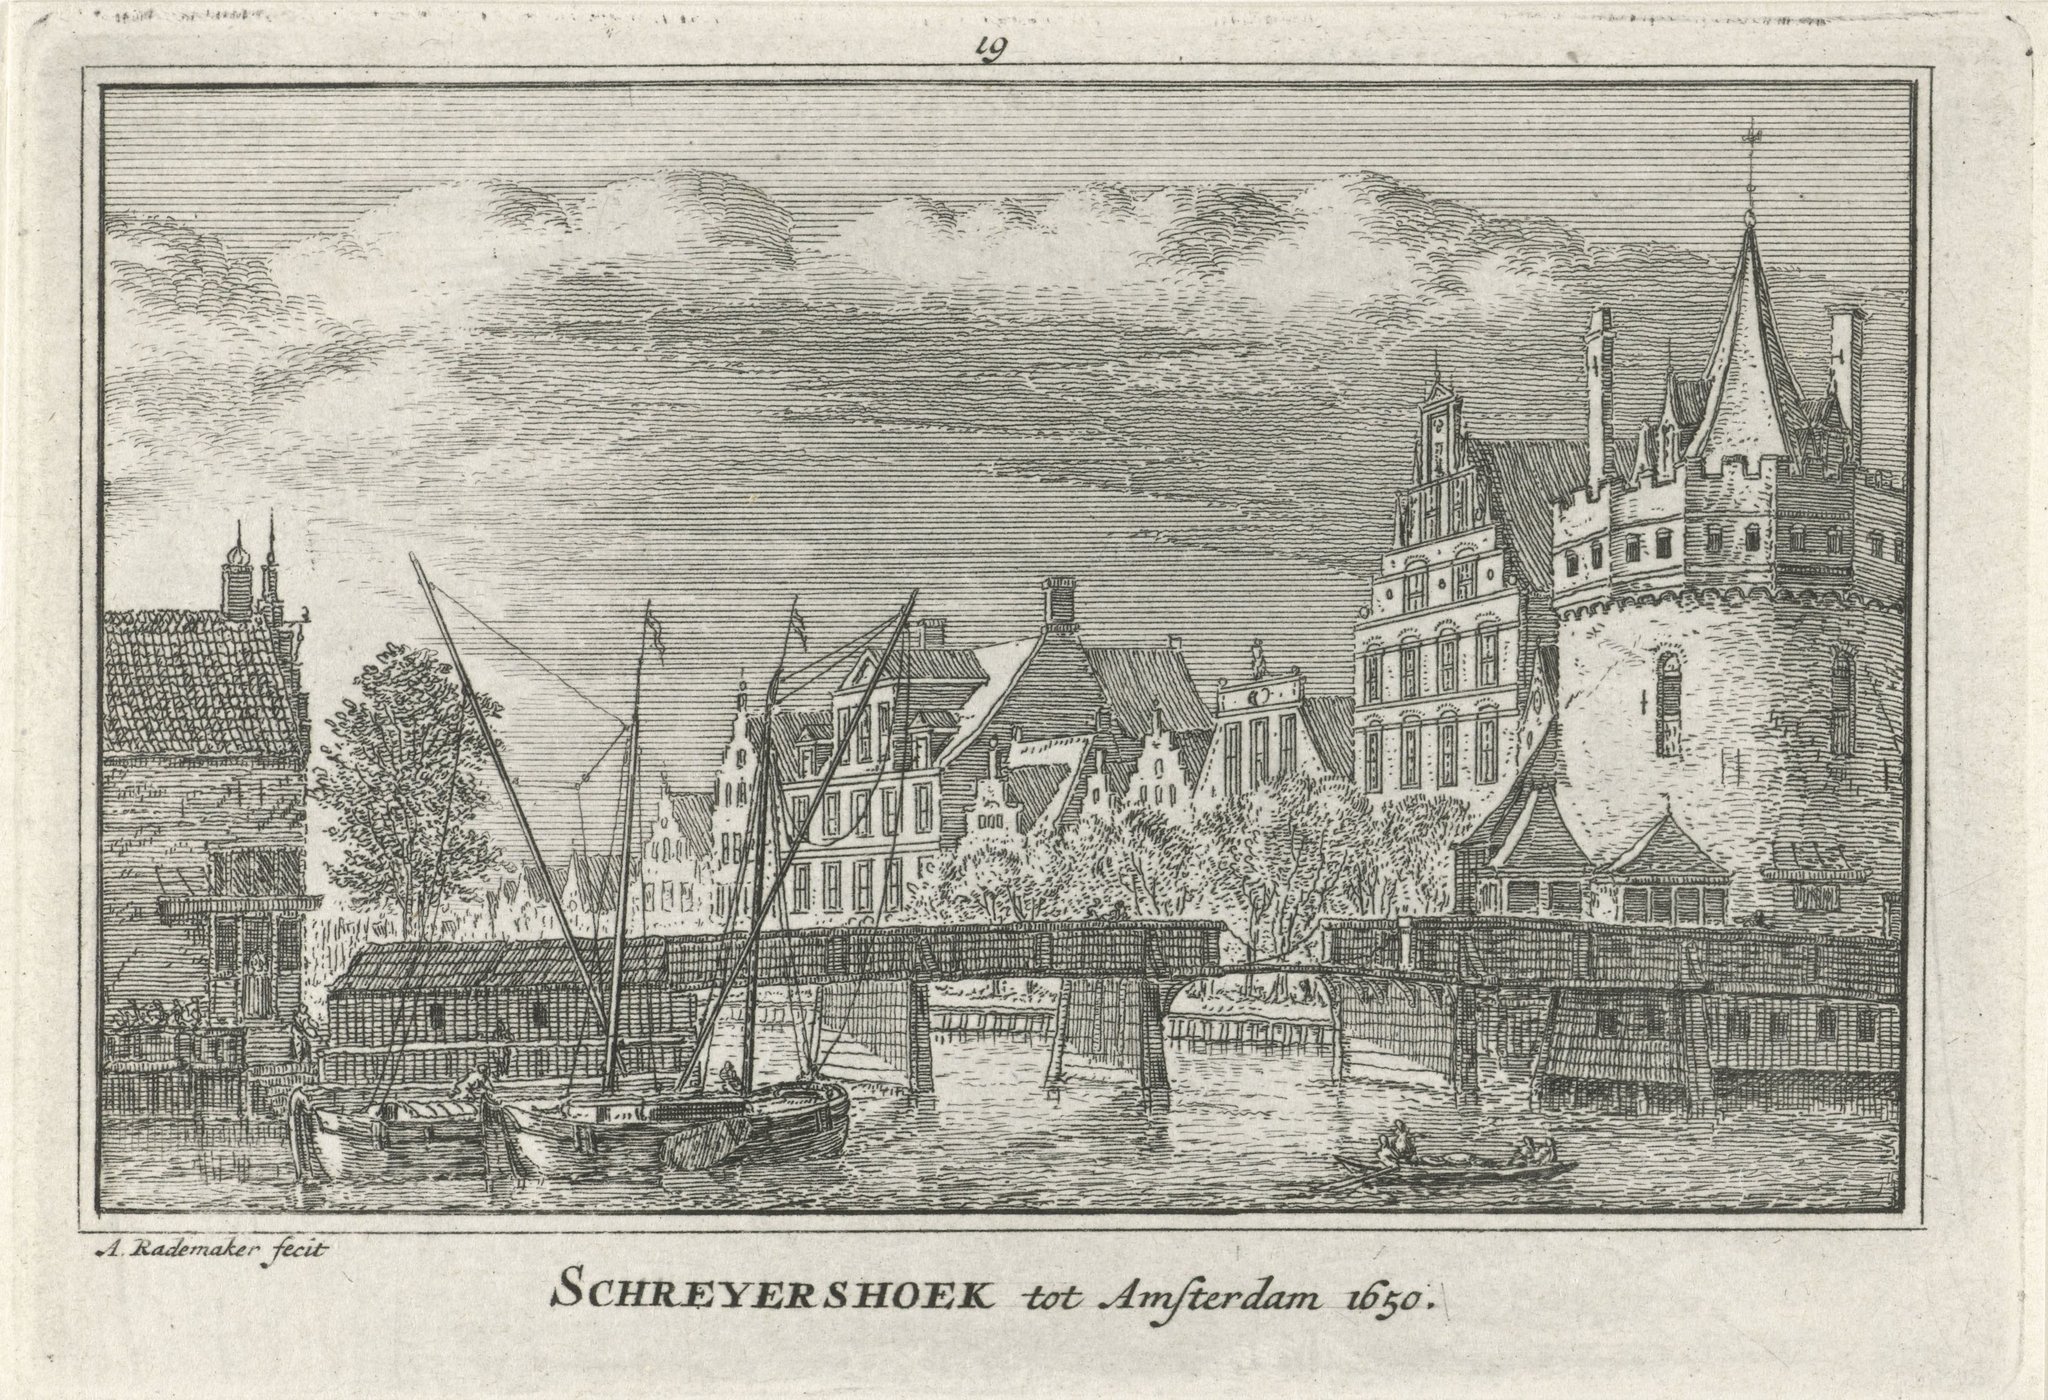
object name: print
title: Schreierstoren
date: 1727-1733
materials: paper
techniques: etching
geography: amsterdam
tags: schreierstoren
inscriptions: collector's mark: Lugt 2228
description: Illustratie uit: Abraham Rademaker, Matthaeus Brouërius van Niedek, Isaac Le Long, Kabinet van Nederlandsche en Kleefsche outheden en (...) voorname stads- en landgebouwen, Willem Barents en Antoni Schoonenburg: Amsterdam, 1727-1733, ill. nr. 19